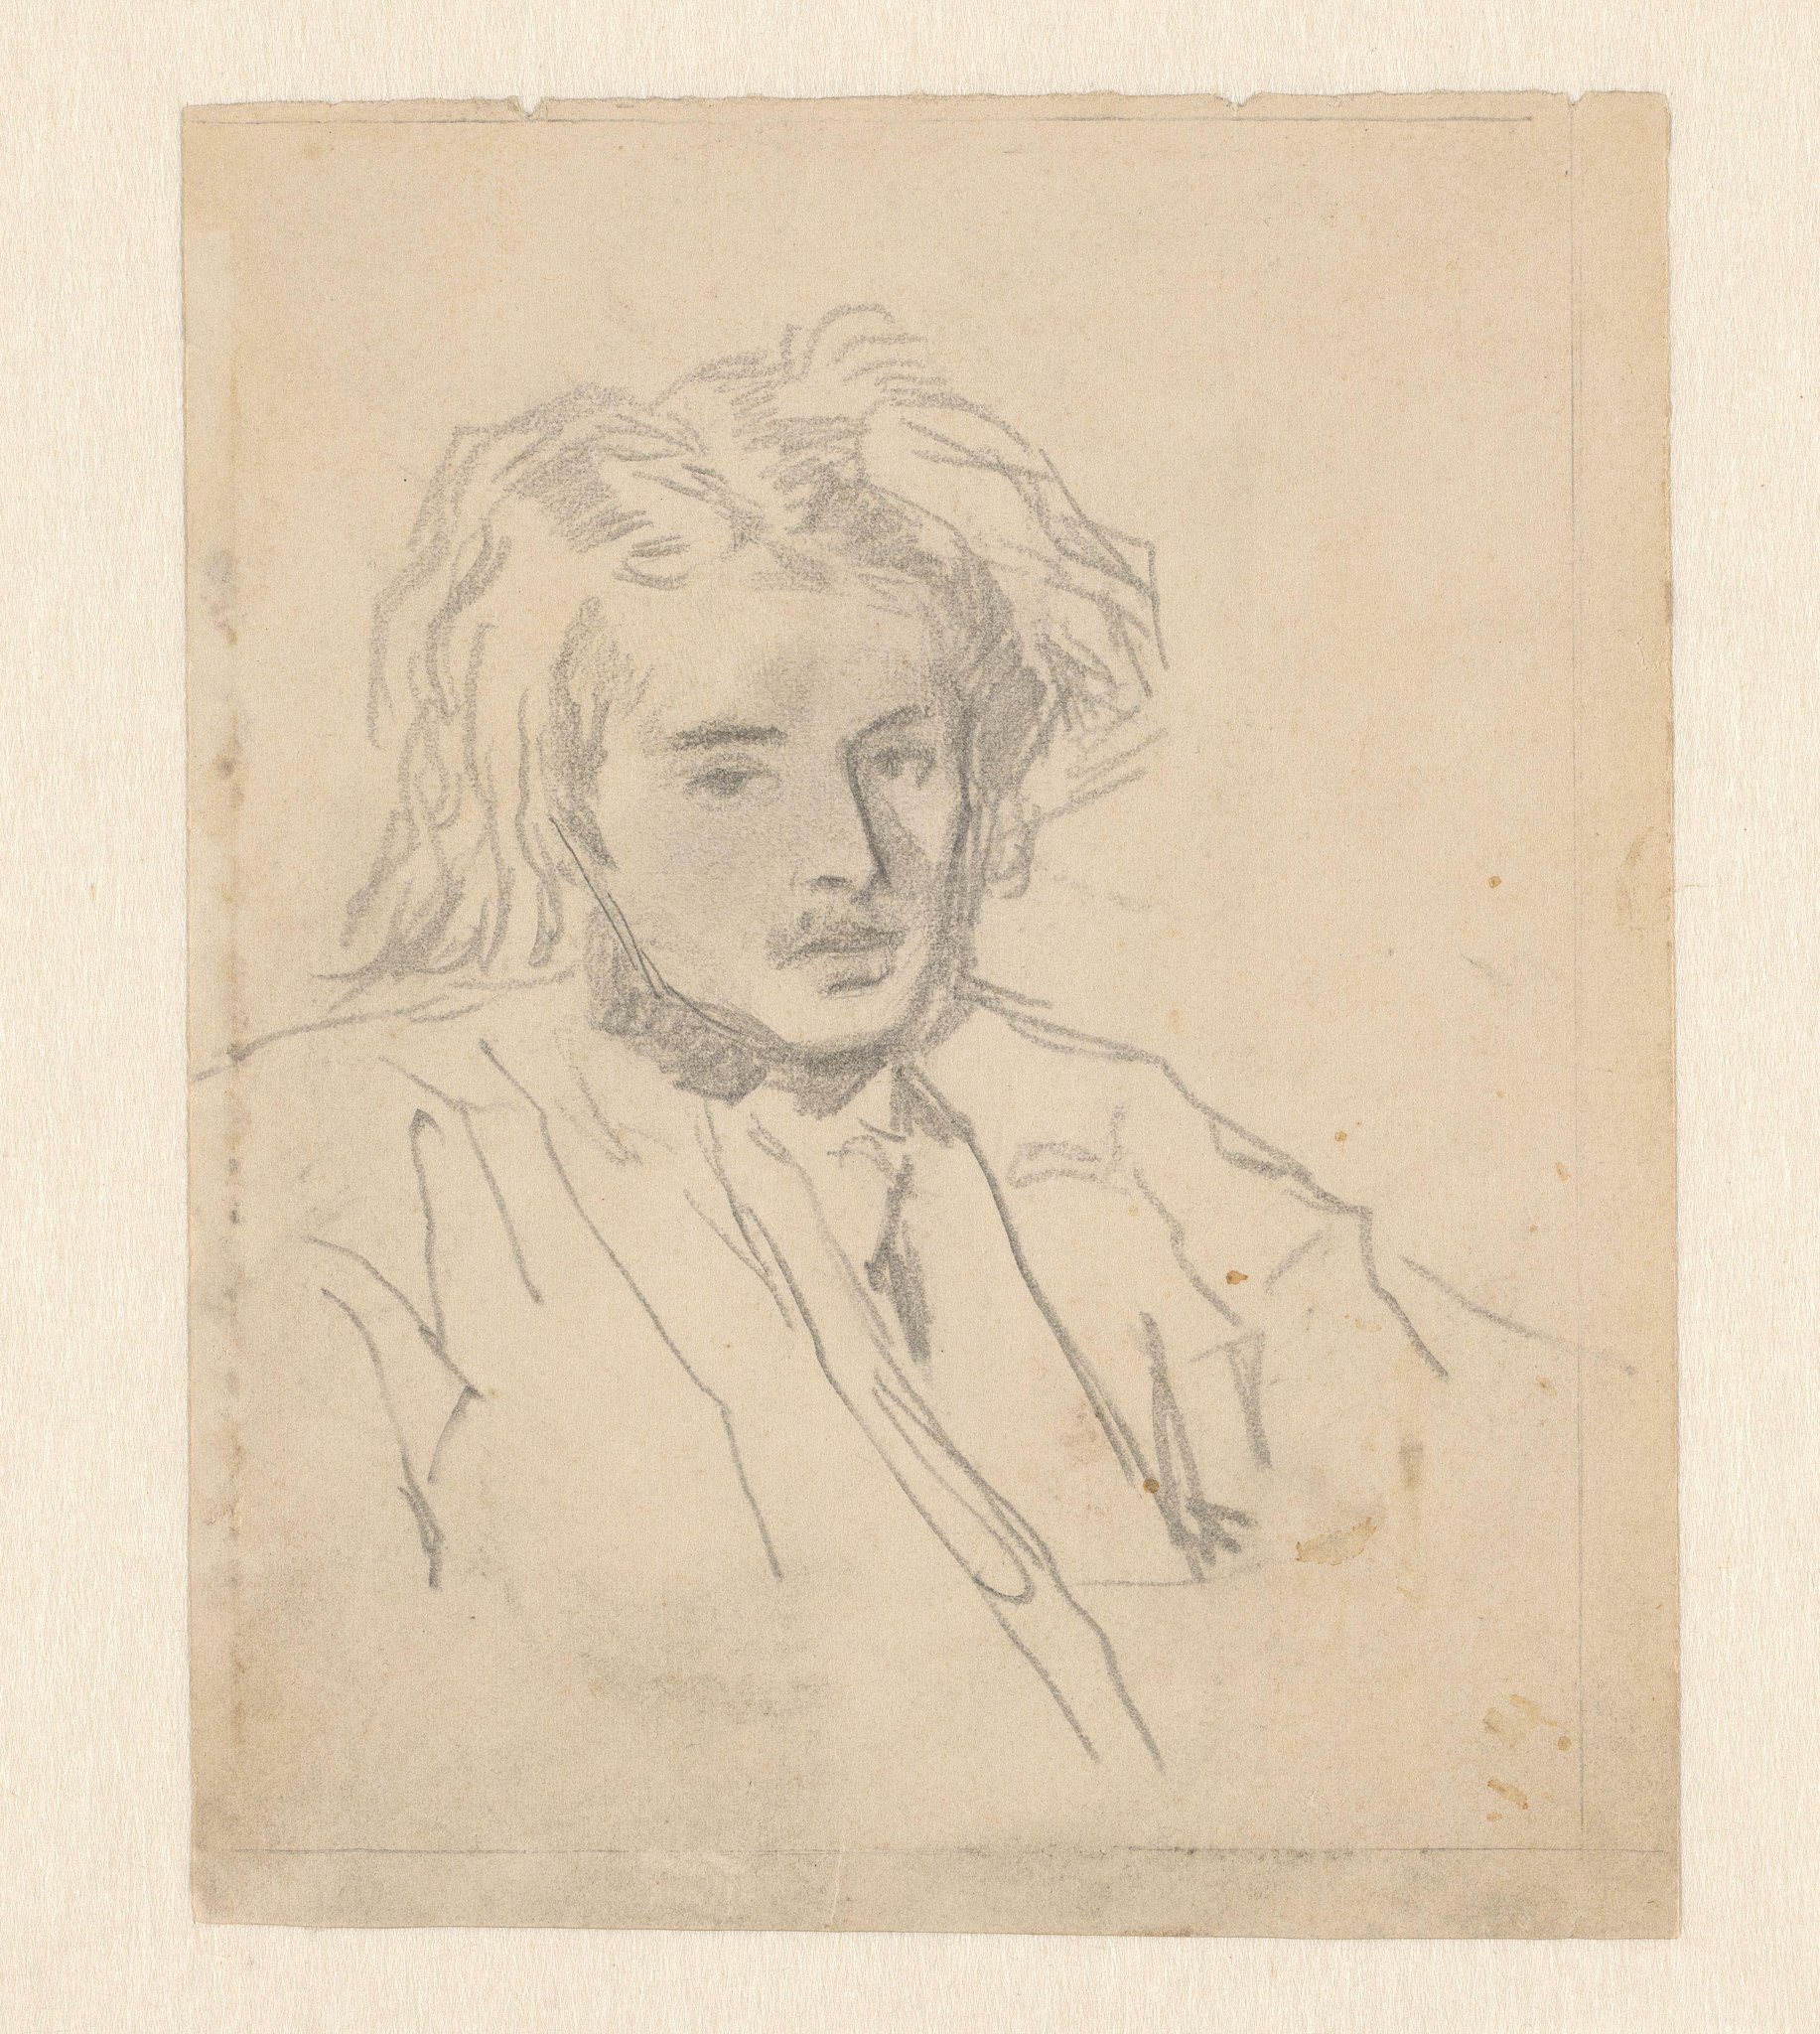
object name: drawing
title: Portretstudie van een jonge man met wilde haardos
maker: matthijs maris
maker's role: draughtsman, painter, print maker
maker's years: 1839-1917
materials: paper, pencil